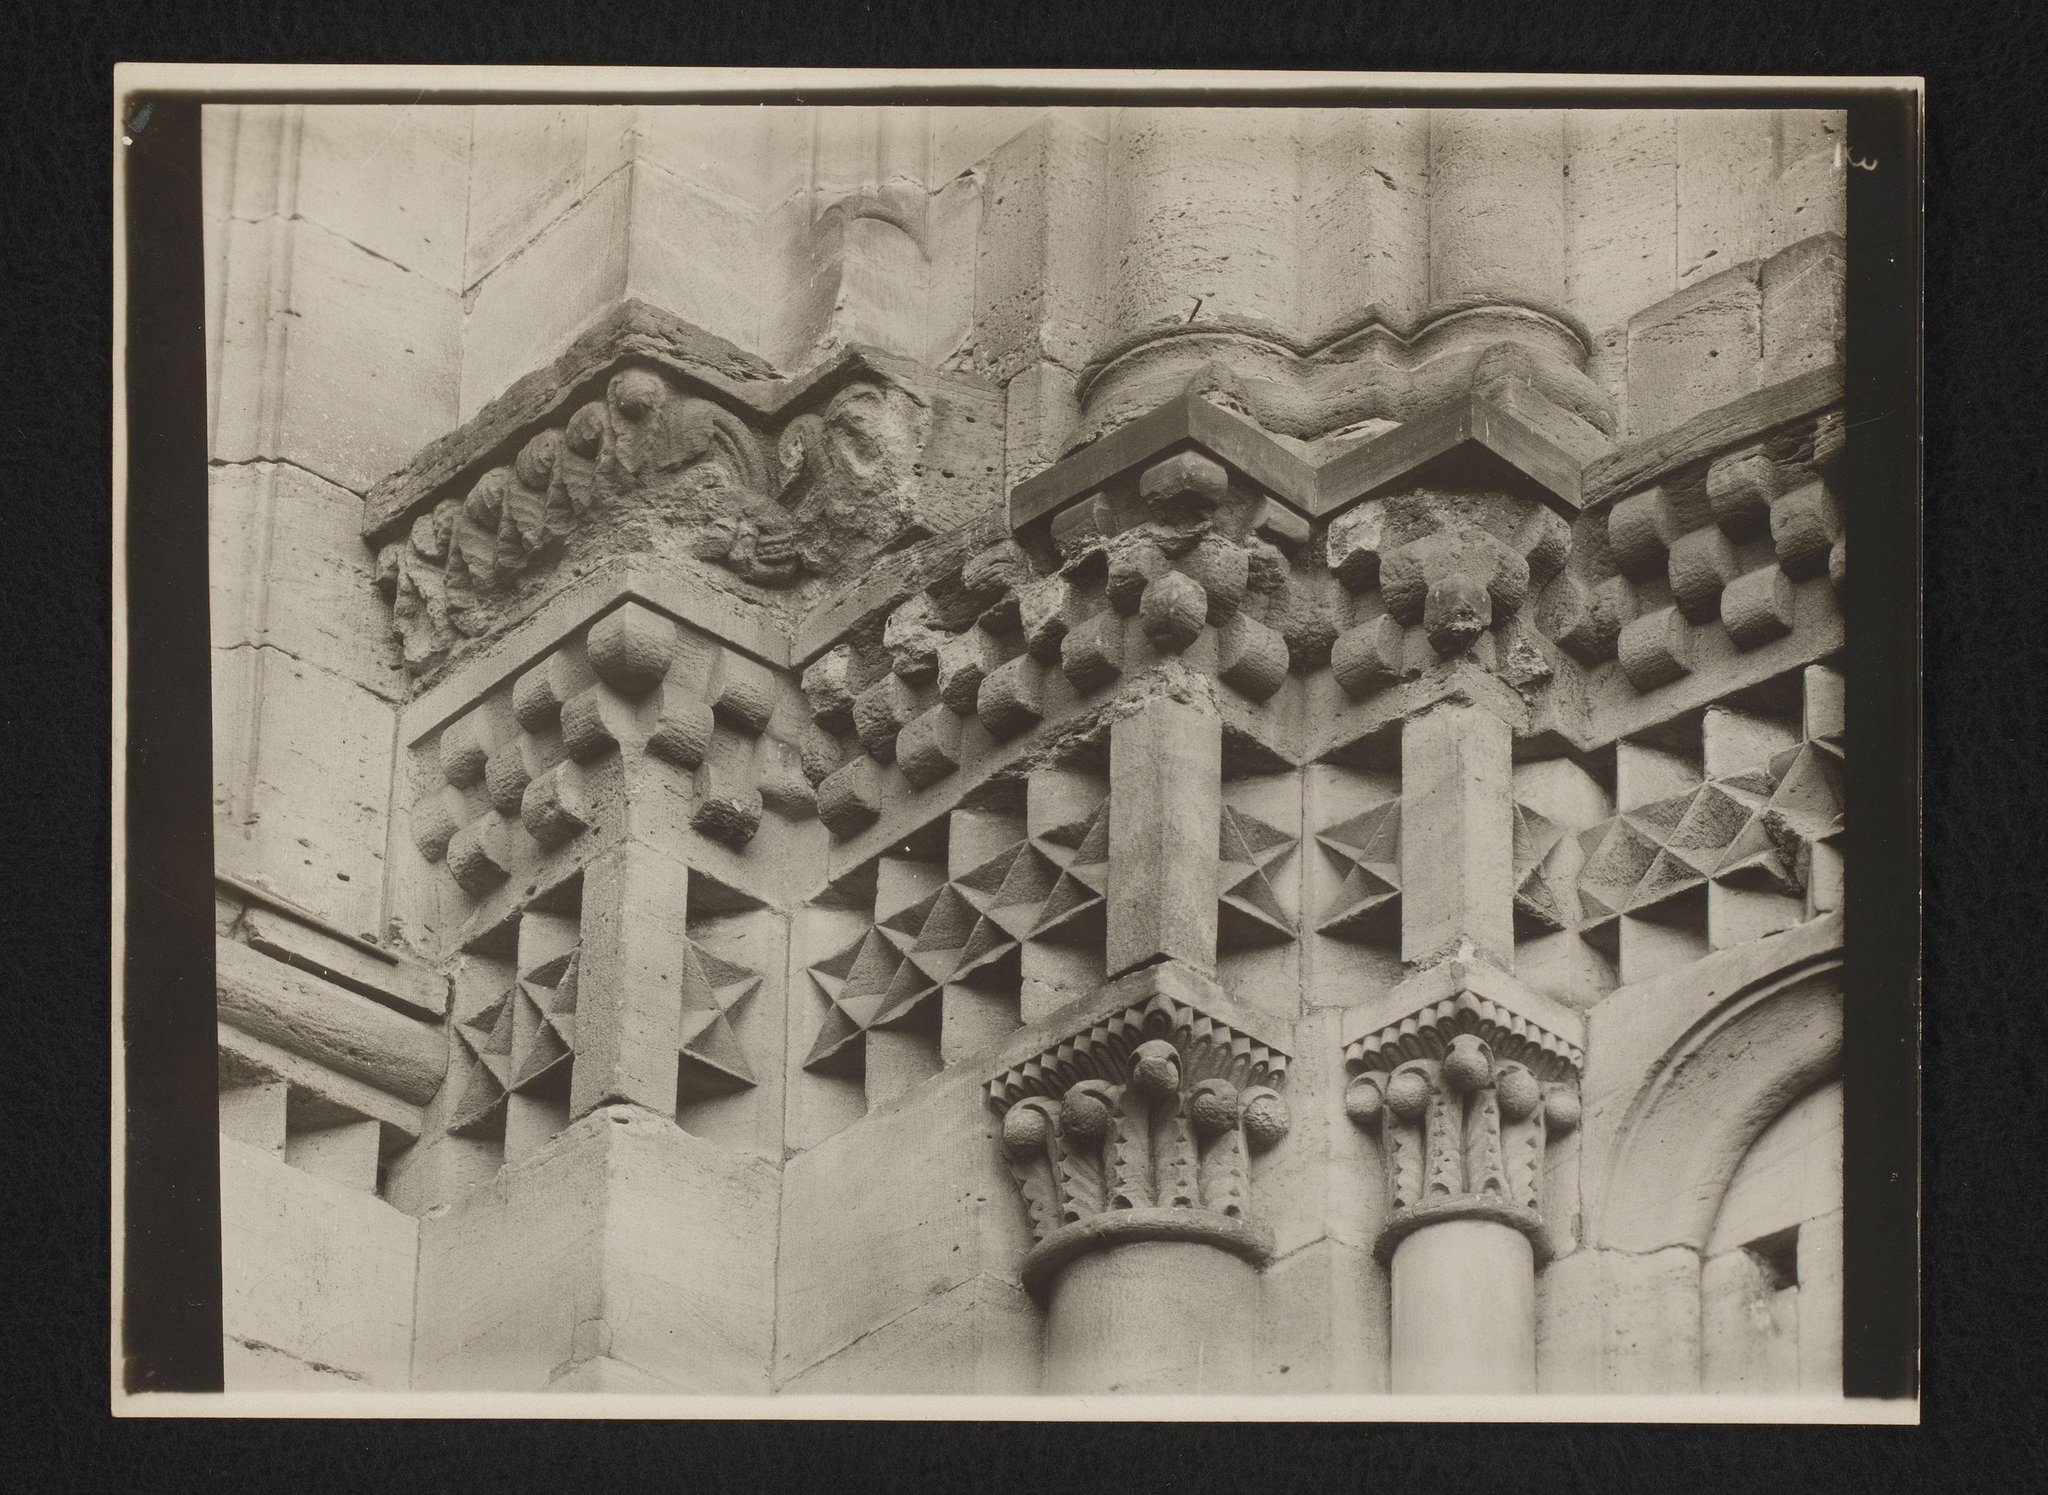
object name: photograph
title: Gezicht op het beeldhouwwerk van een fries van de dom van Bamberg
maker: Anonymous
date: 1900-1920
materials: paper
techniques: gelatin silver print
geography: bamberg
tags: church (exterior)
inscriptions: inscription: ‘Kunsthist. Seminar/ Marburg (Lahn)/ Photogr. Abteilung/ Vervielfältigung/ untersagt.’